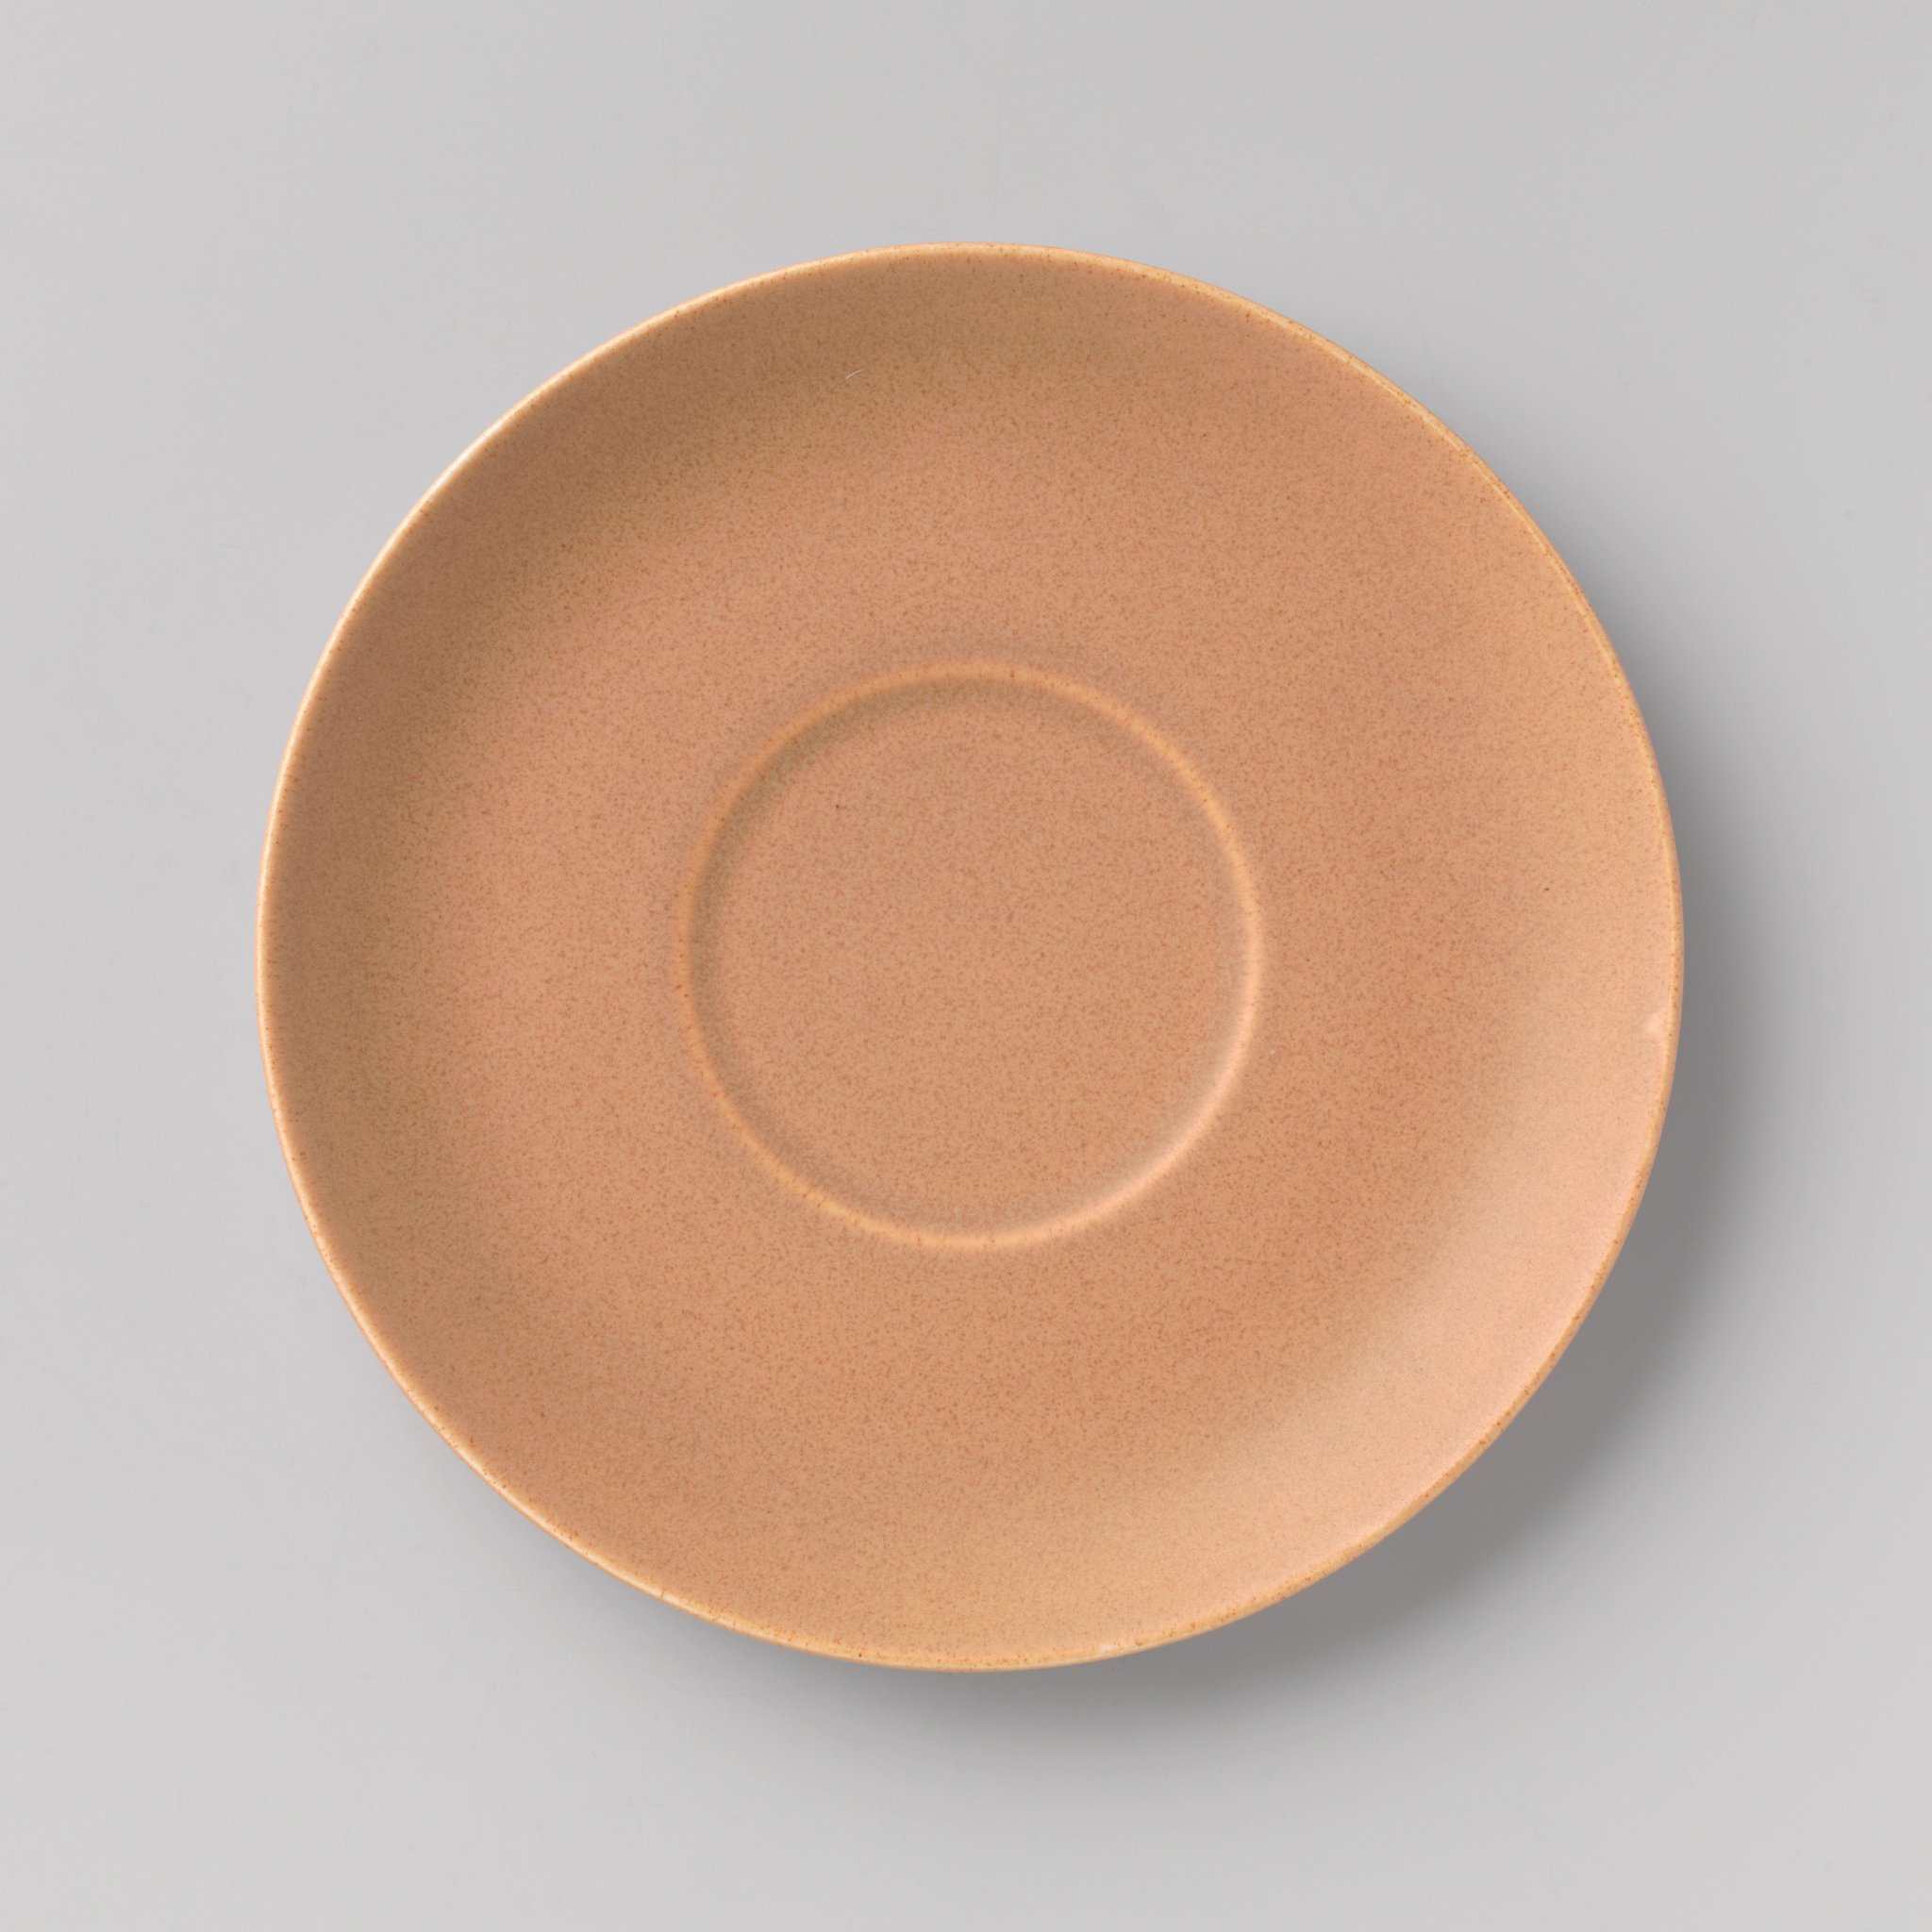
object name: platter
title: Schotel, deel van een theeservies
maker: edmond bellefroid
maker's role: ceramicist, painter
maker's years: 1893-1971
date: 1934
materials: earthenware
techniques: painted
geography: maastricht